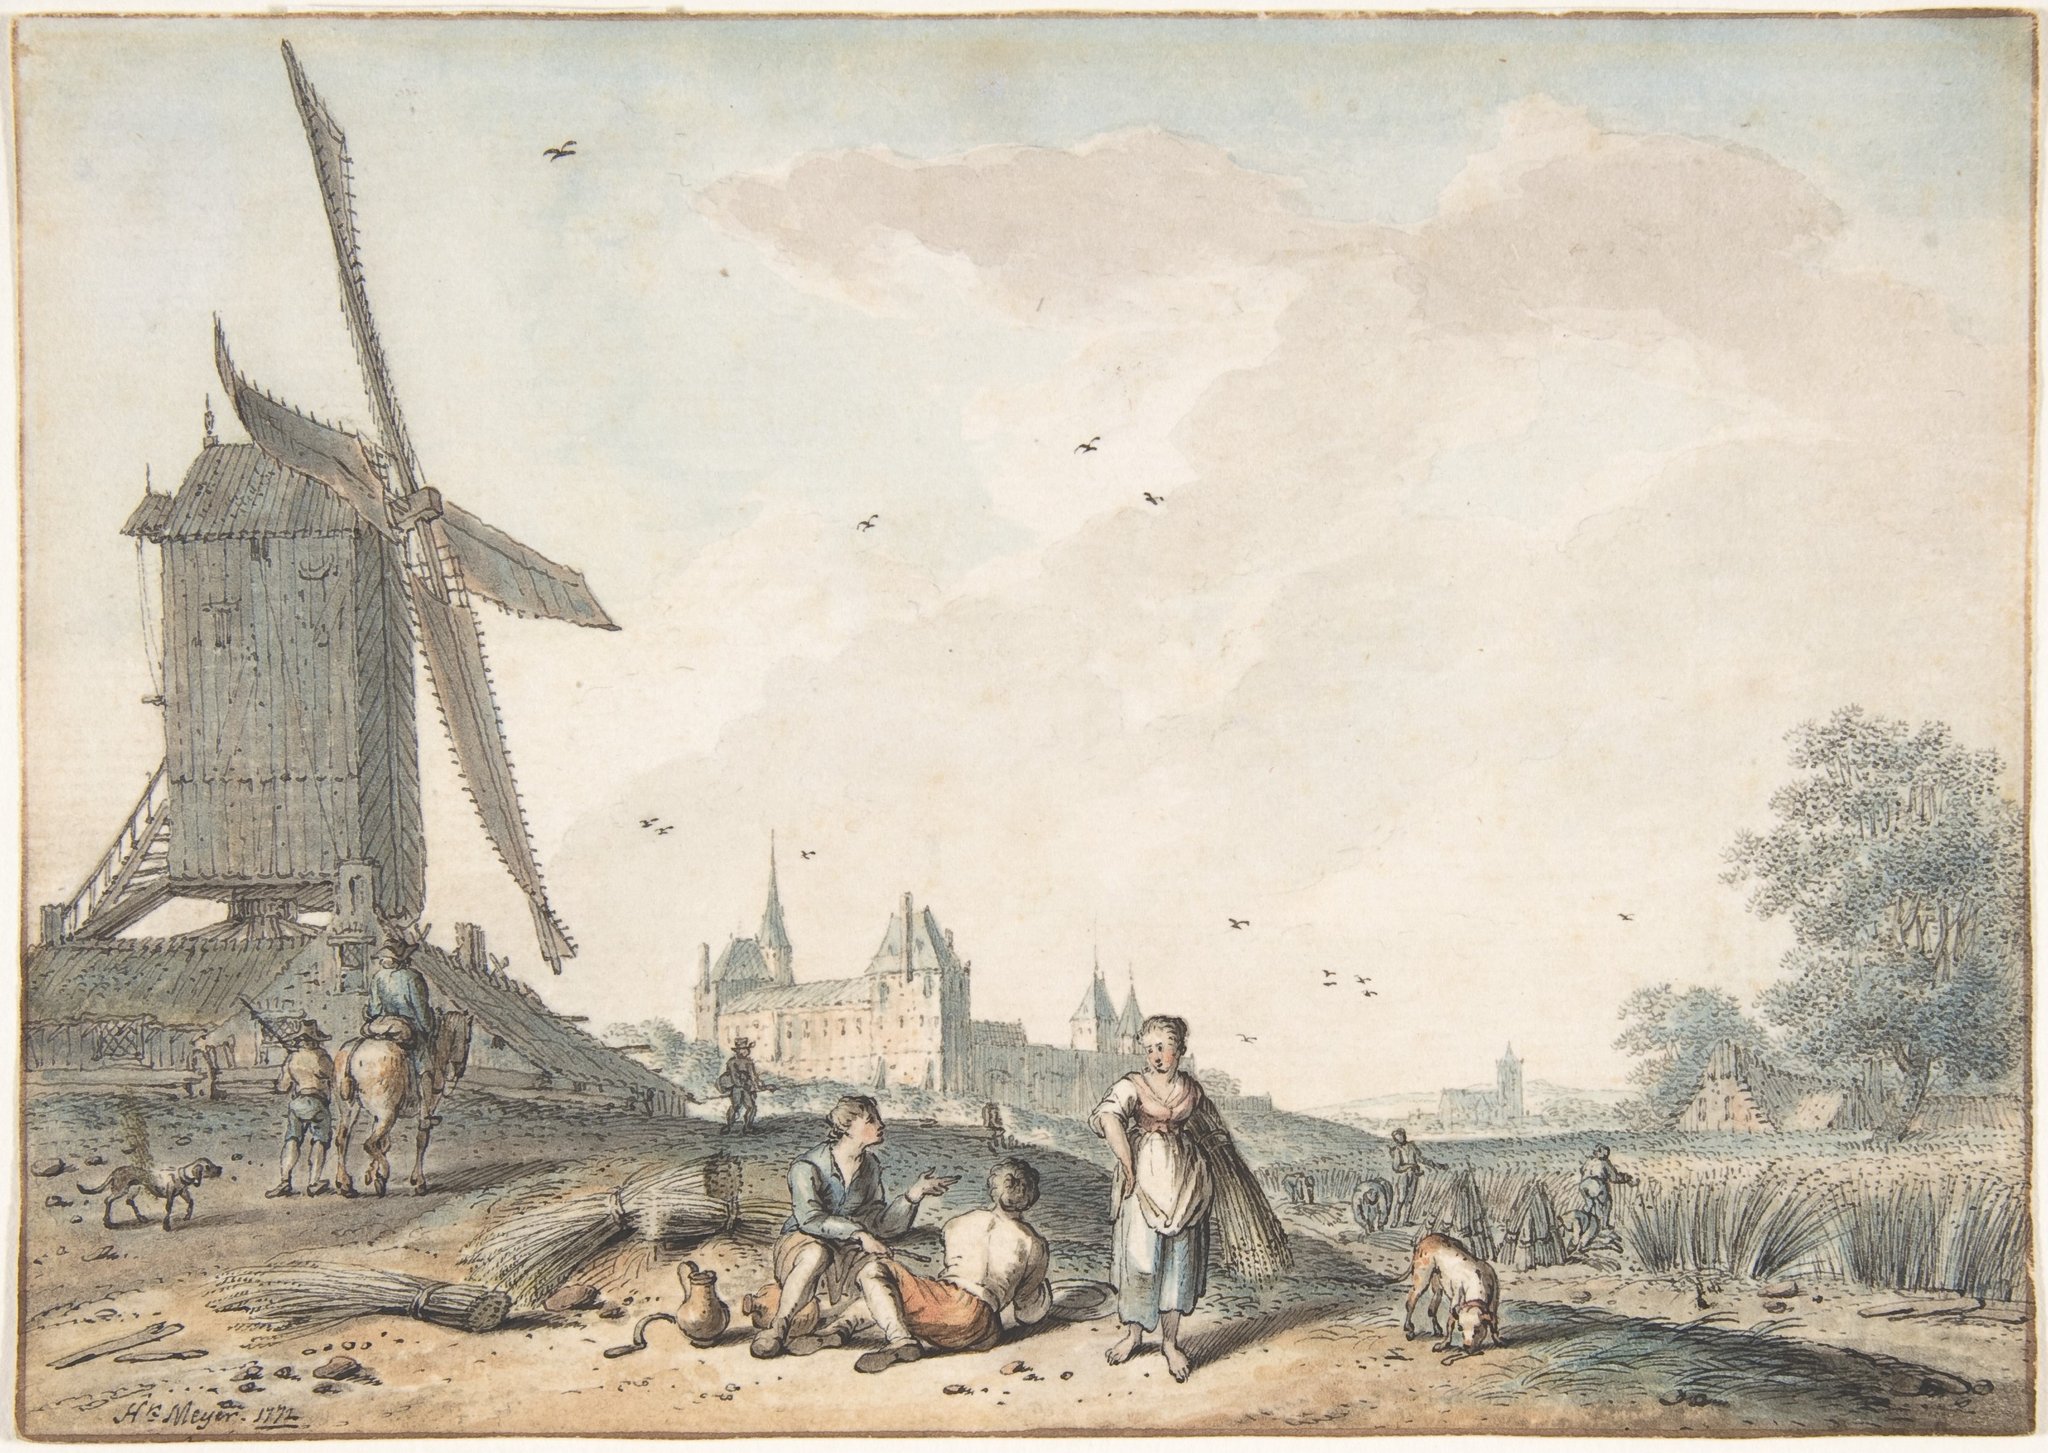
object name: drawing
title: August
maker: hendrik meijer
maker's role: artist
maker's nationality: dutch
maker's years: 1744-1793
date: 1772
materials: chalk, ink, watercolor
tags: buildings,windmills,women,dogs,horses